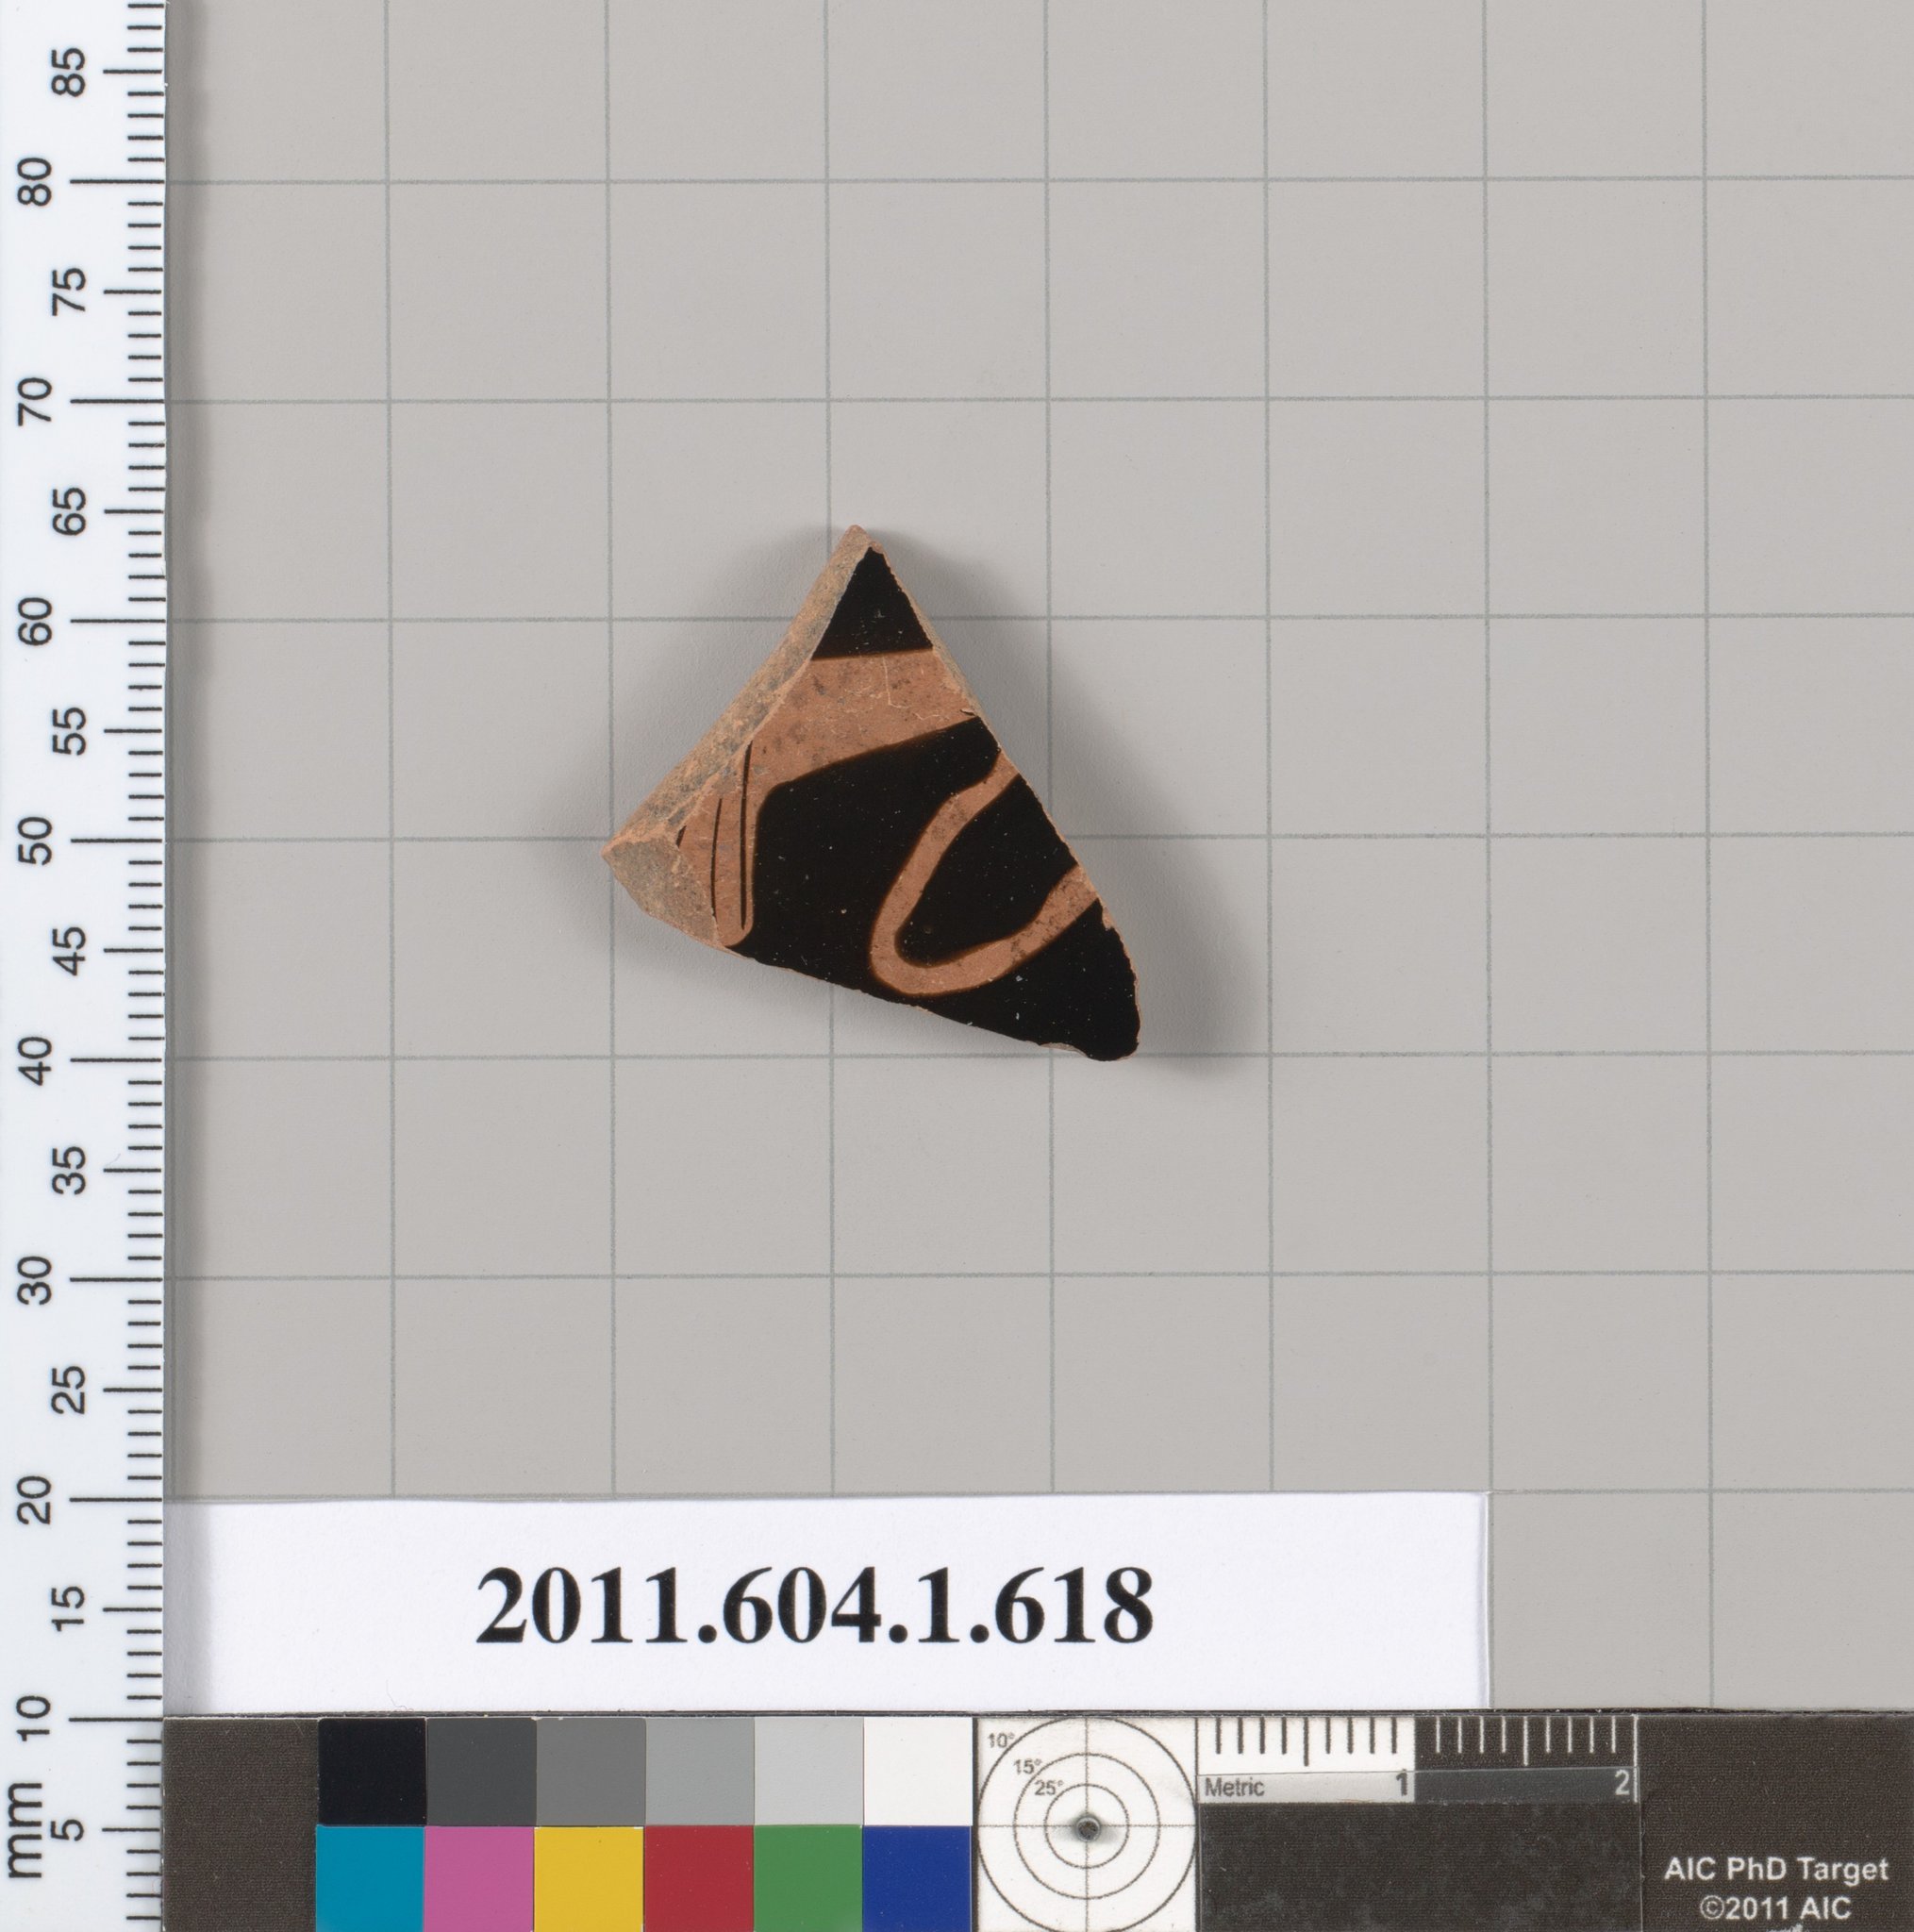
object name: kylix fragment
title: Terracotta fragment of a kylix (drinking cup)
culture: greek, attic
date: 475-451 BCE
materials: terracotta